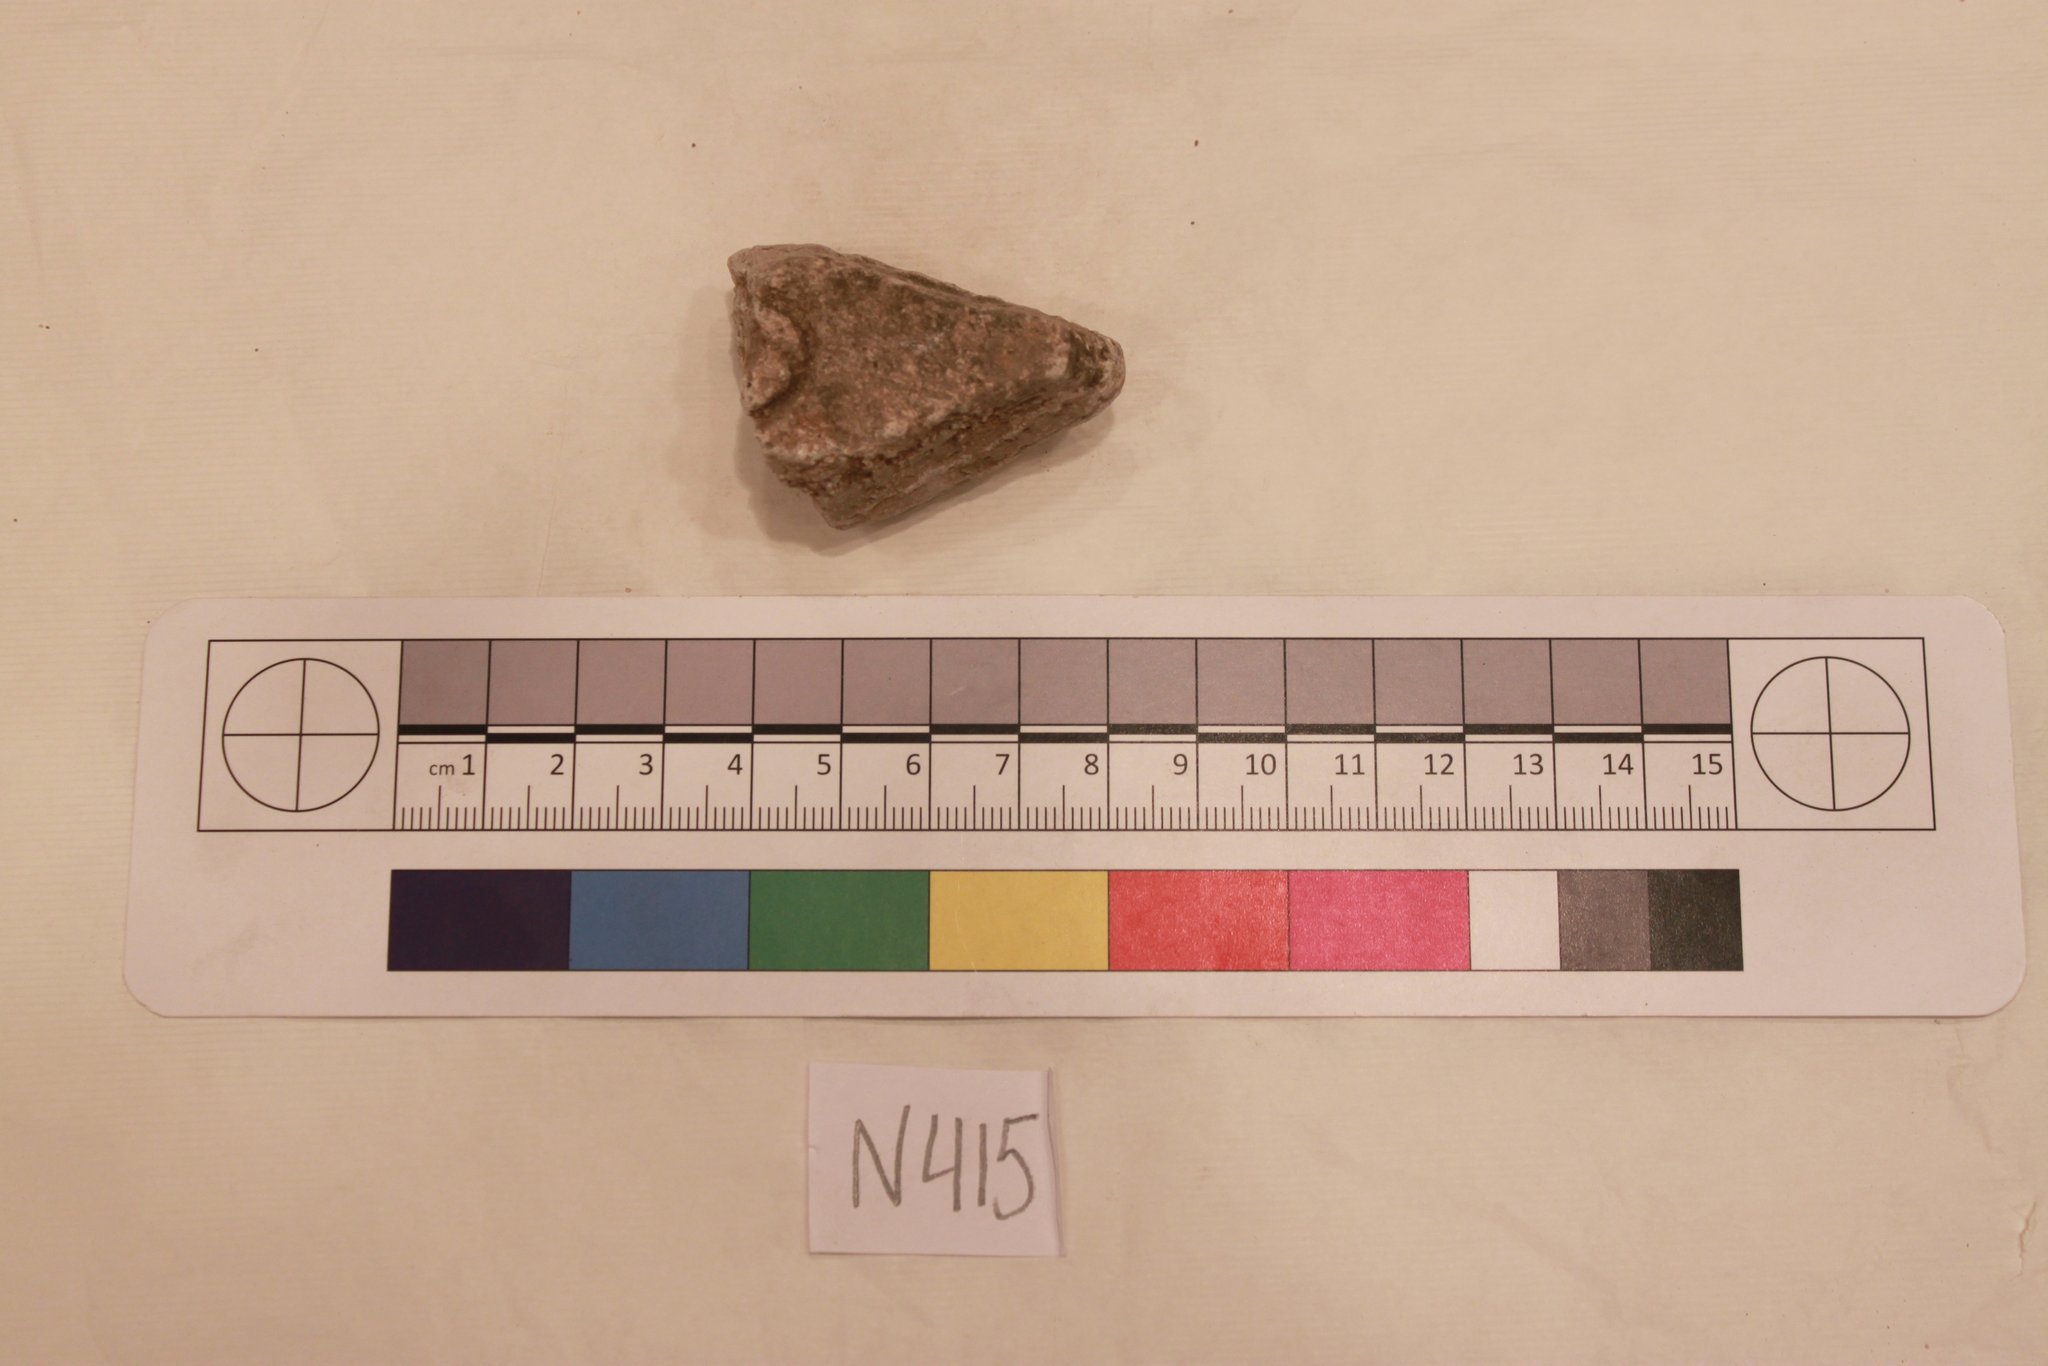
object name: fragment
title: Stucco Fragment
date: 701-1200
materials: plaster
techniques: carving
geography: iran